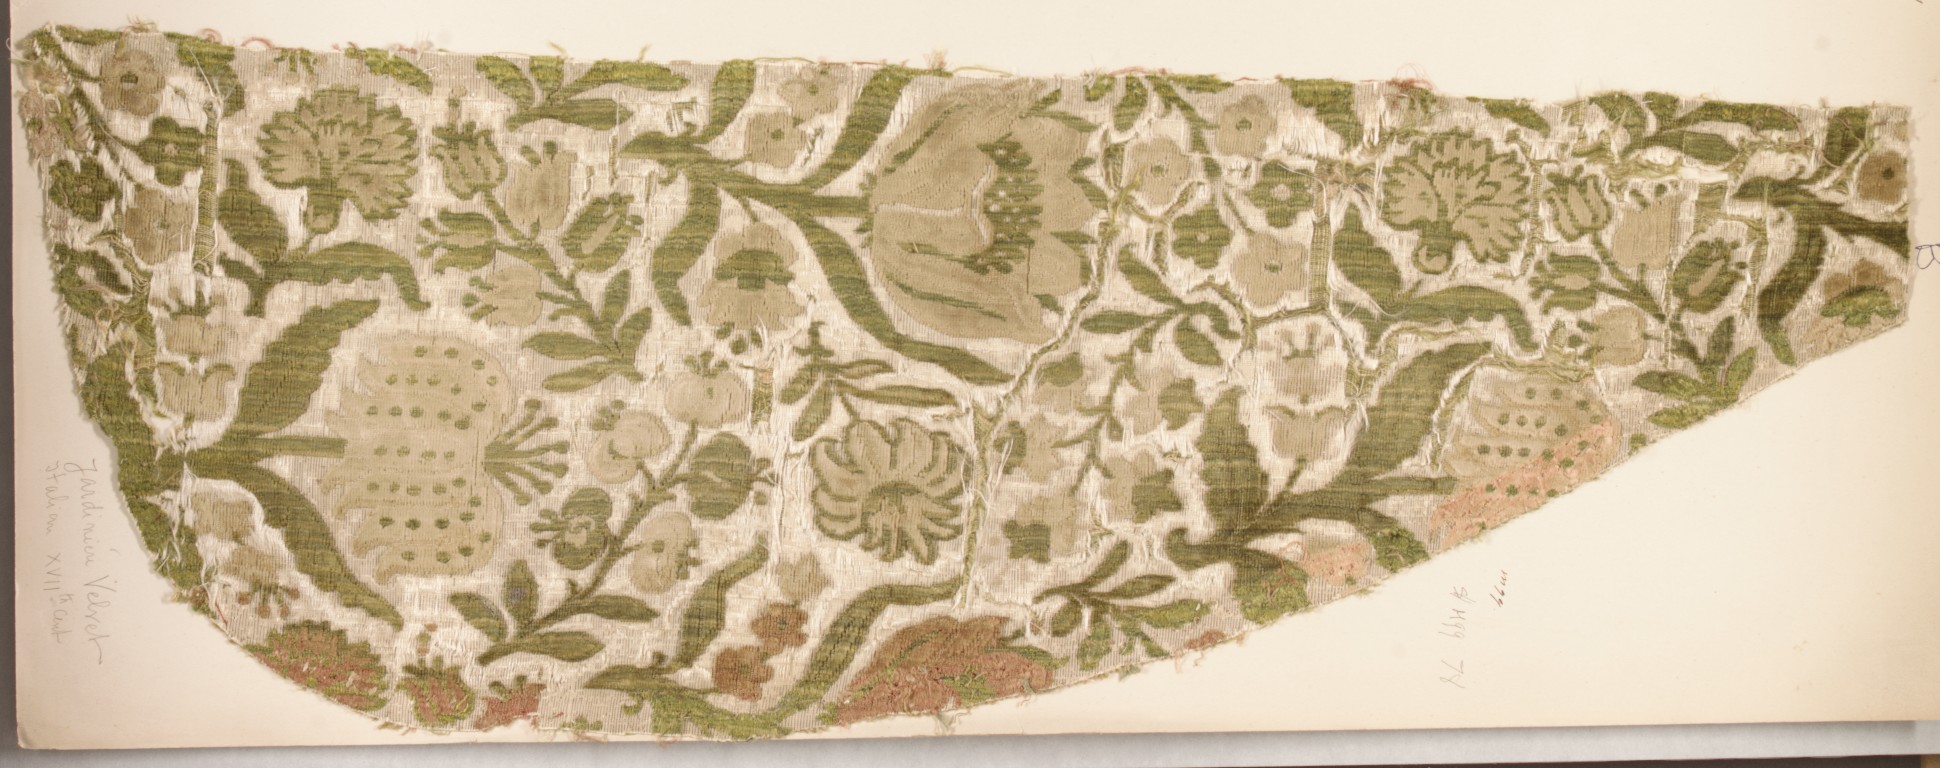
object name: fragment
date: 1601-1700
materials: silk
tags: flowers,leaves